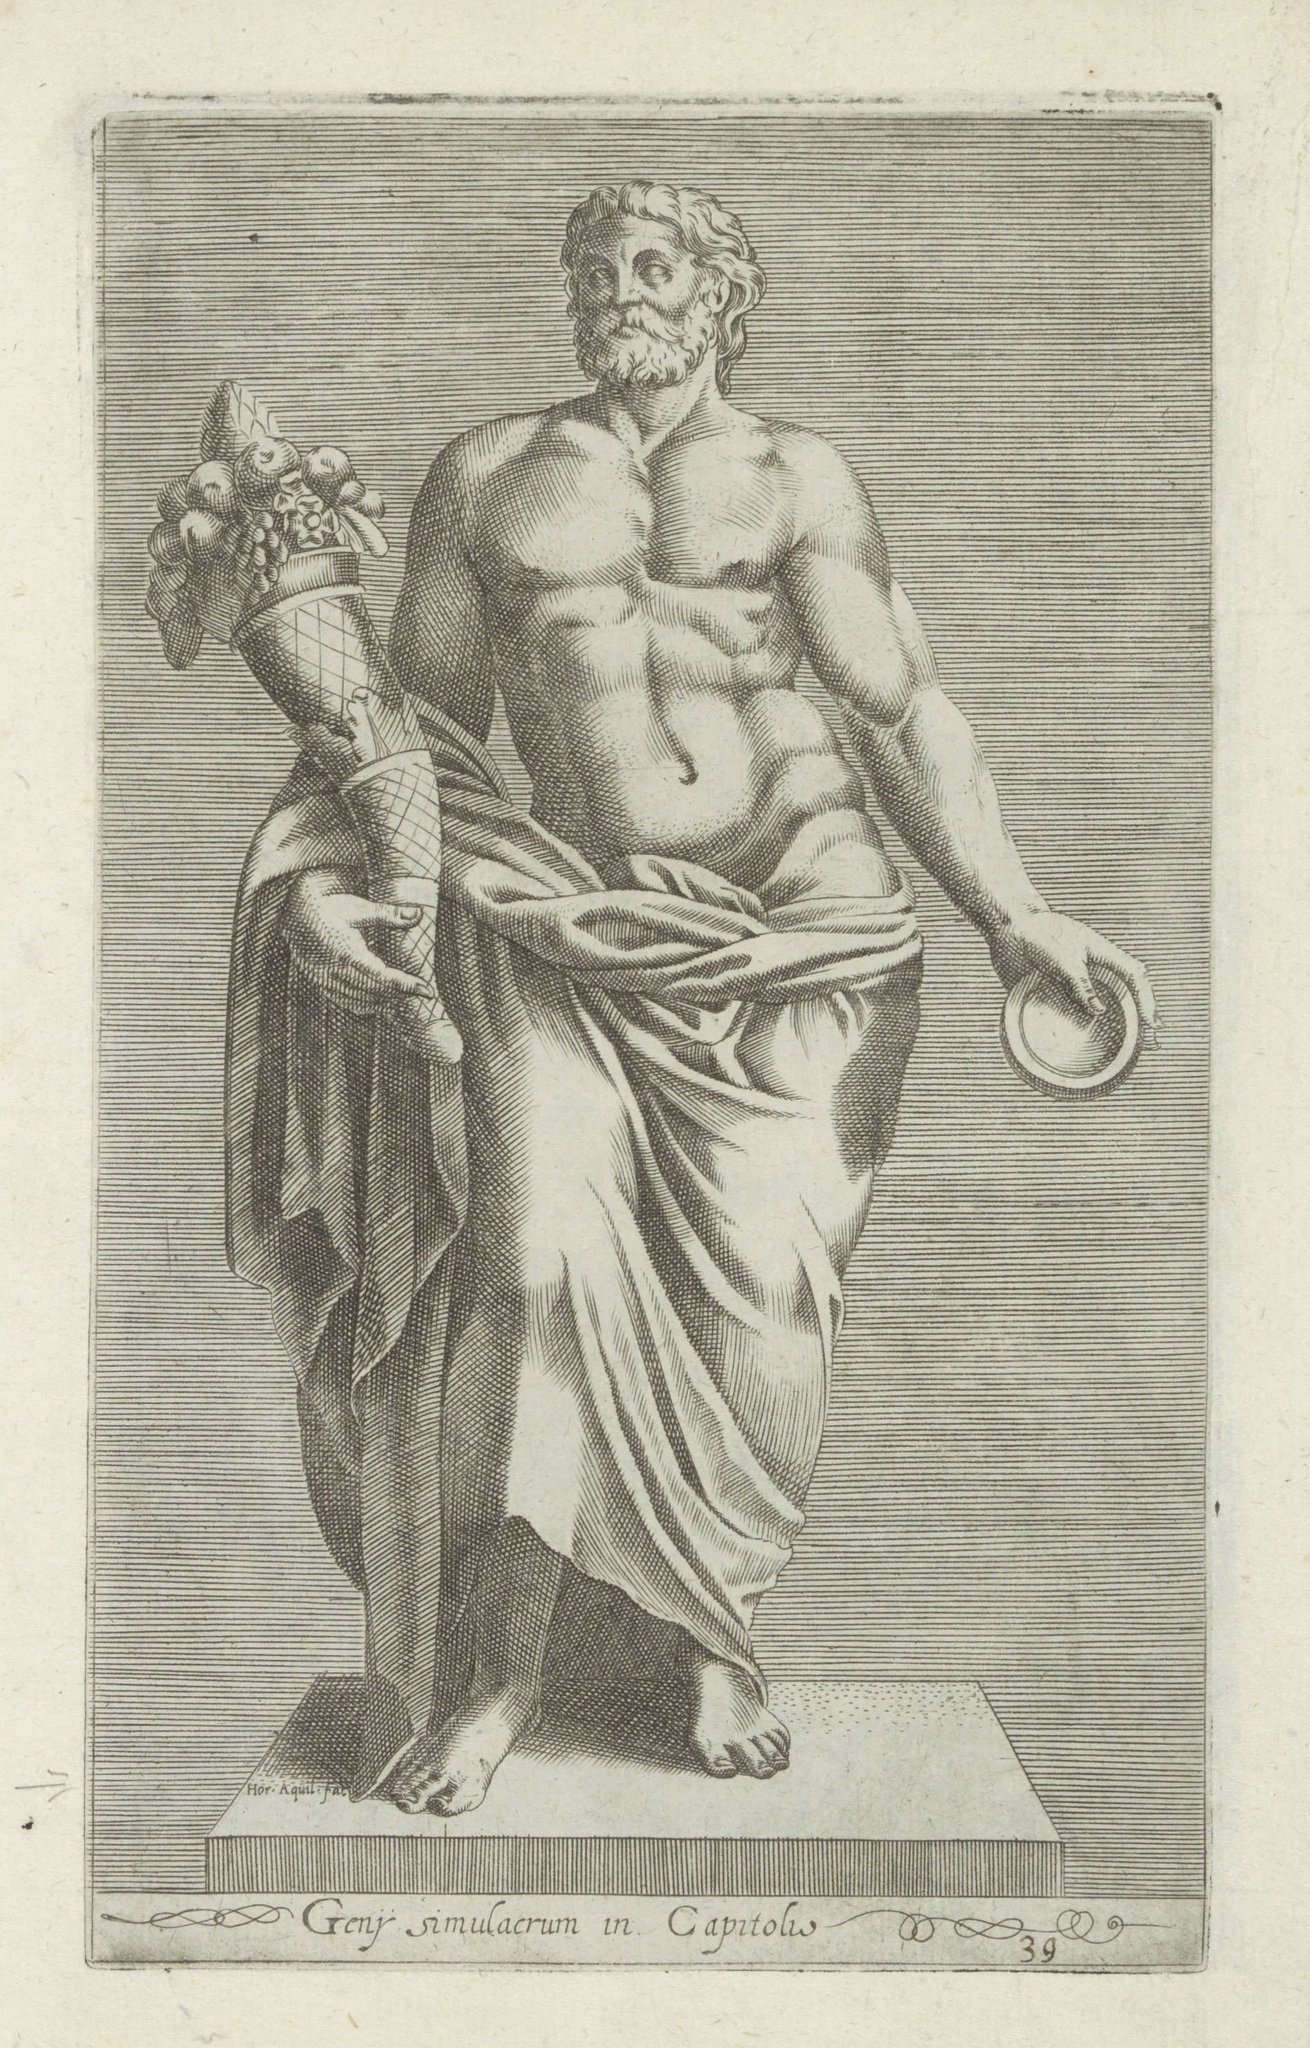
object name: album leaf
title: Antiquarum statuarum urbis Romae quae in publicis locis visuntur icones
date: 1584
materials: paper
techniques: engraving, intaglio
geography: italy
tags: piece of sculpture, reproduction of a piece of sculpture, man (showing himself) undressed, quasi-nude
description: Deze prent maakt deel uit van een set van 79 prenten (+ titelprent) met voorstellingen van antieke sculpturen in Rome.